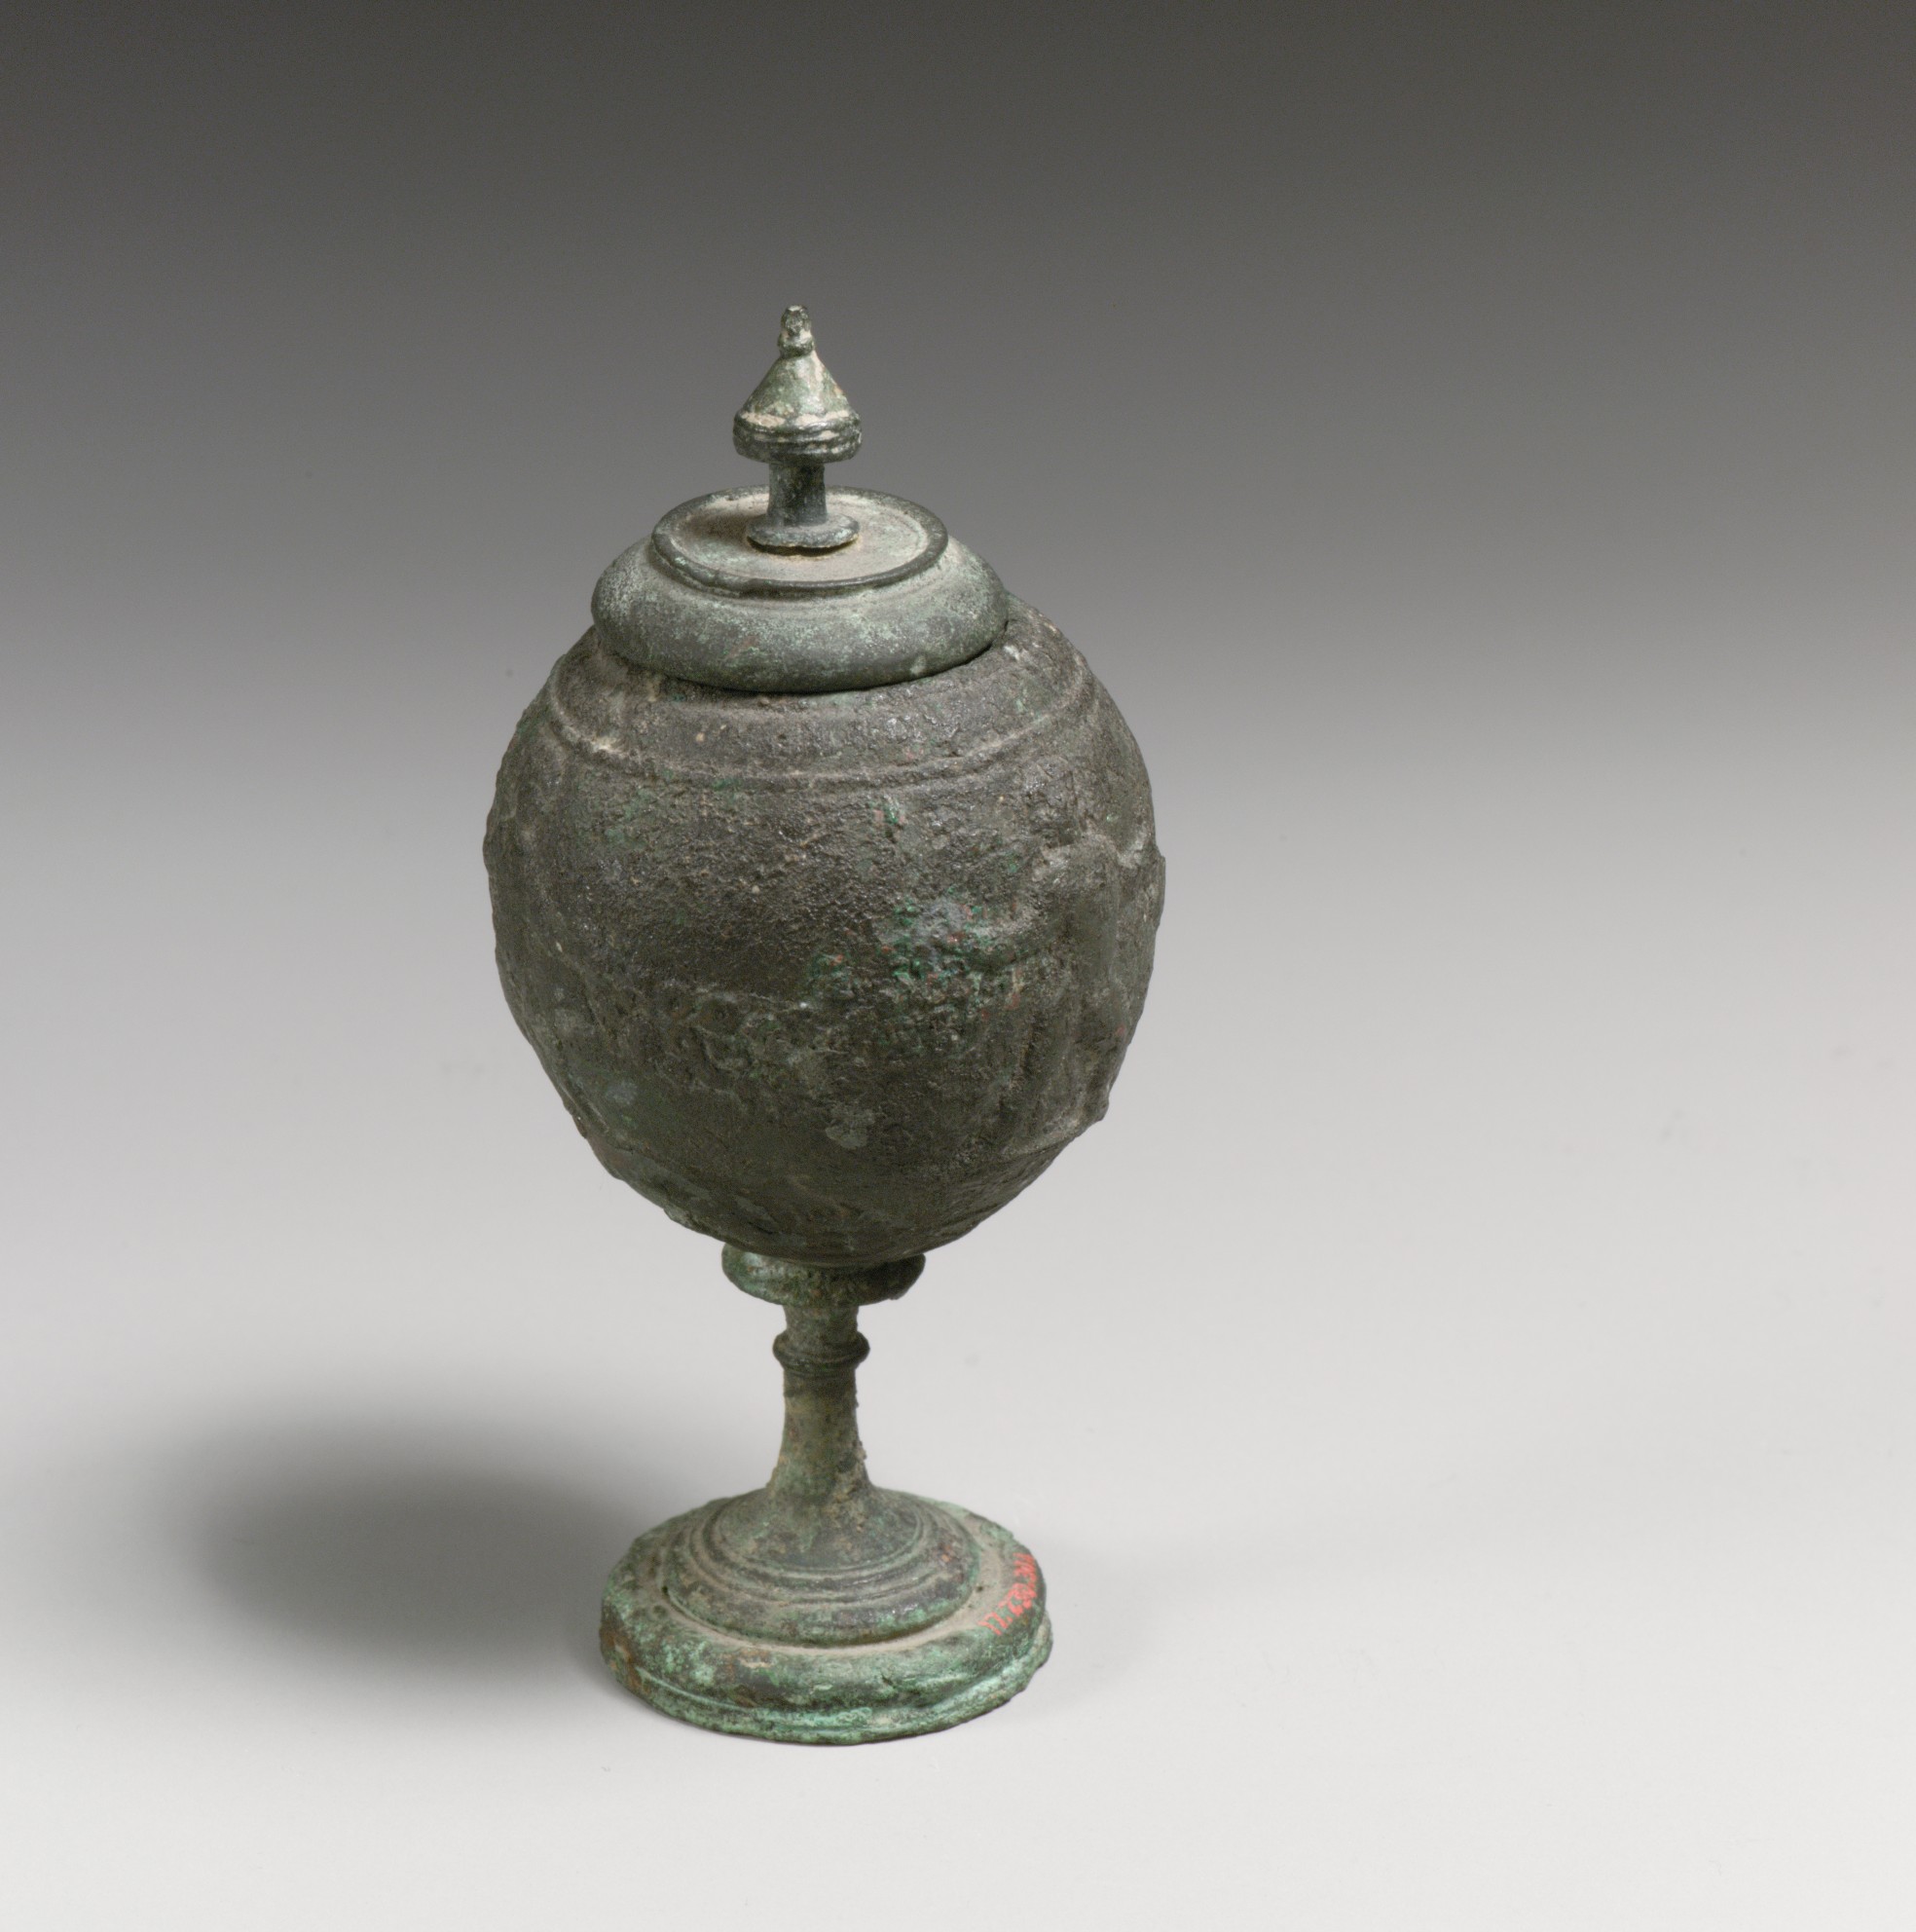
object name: pyxis with lid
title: Bronze footed globular vessel with lid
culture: roman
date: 1-200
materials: bronze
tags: children,rabbits